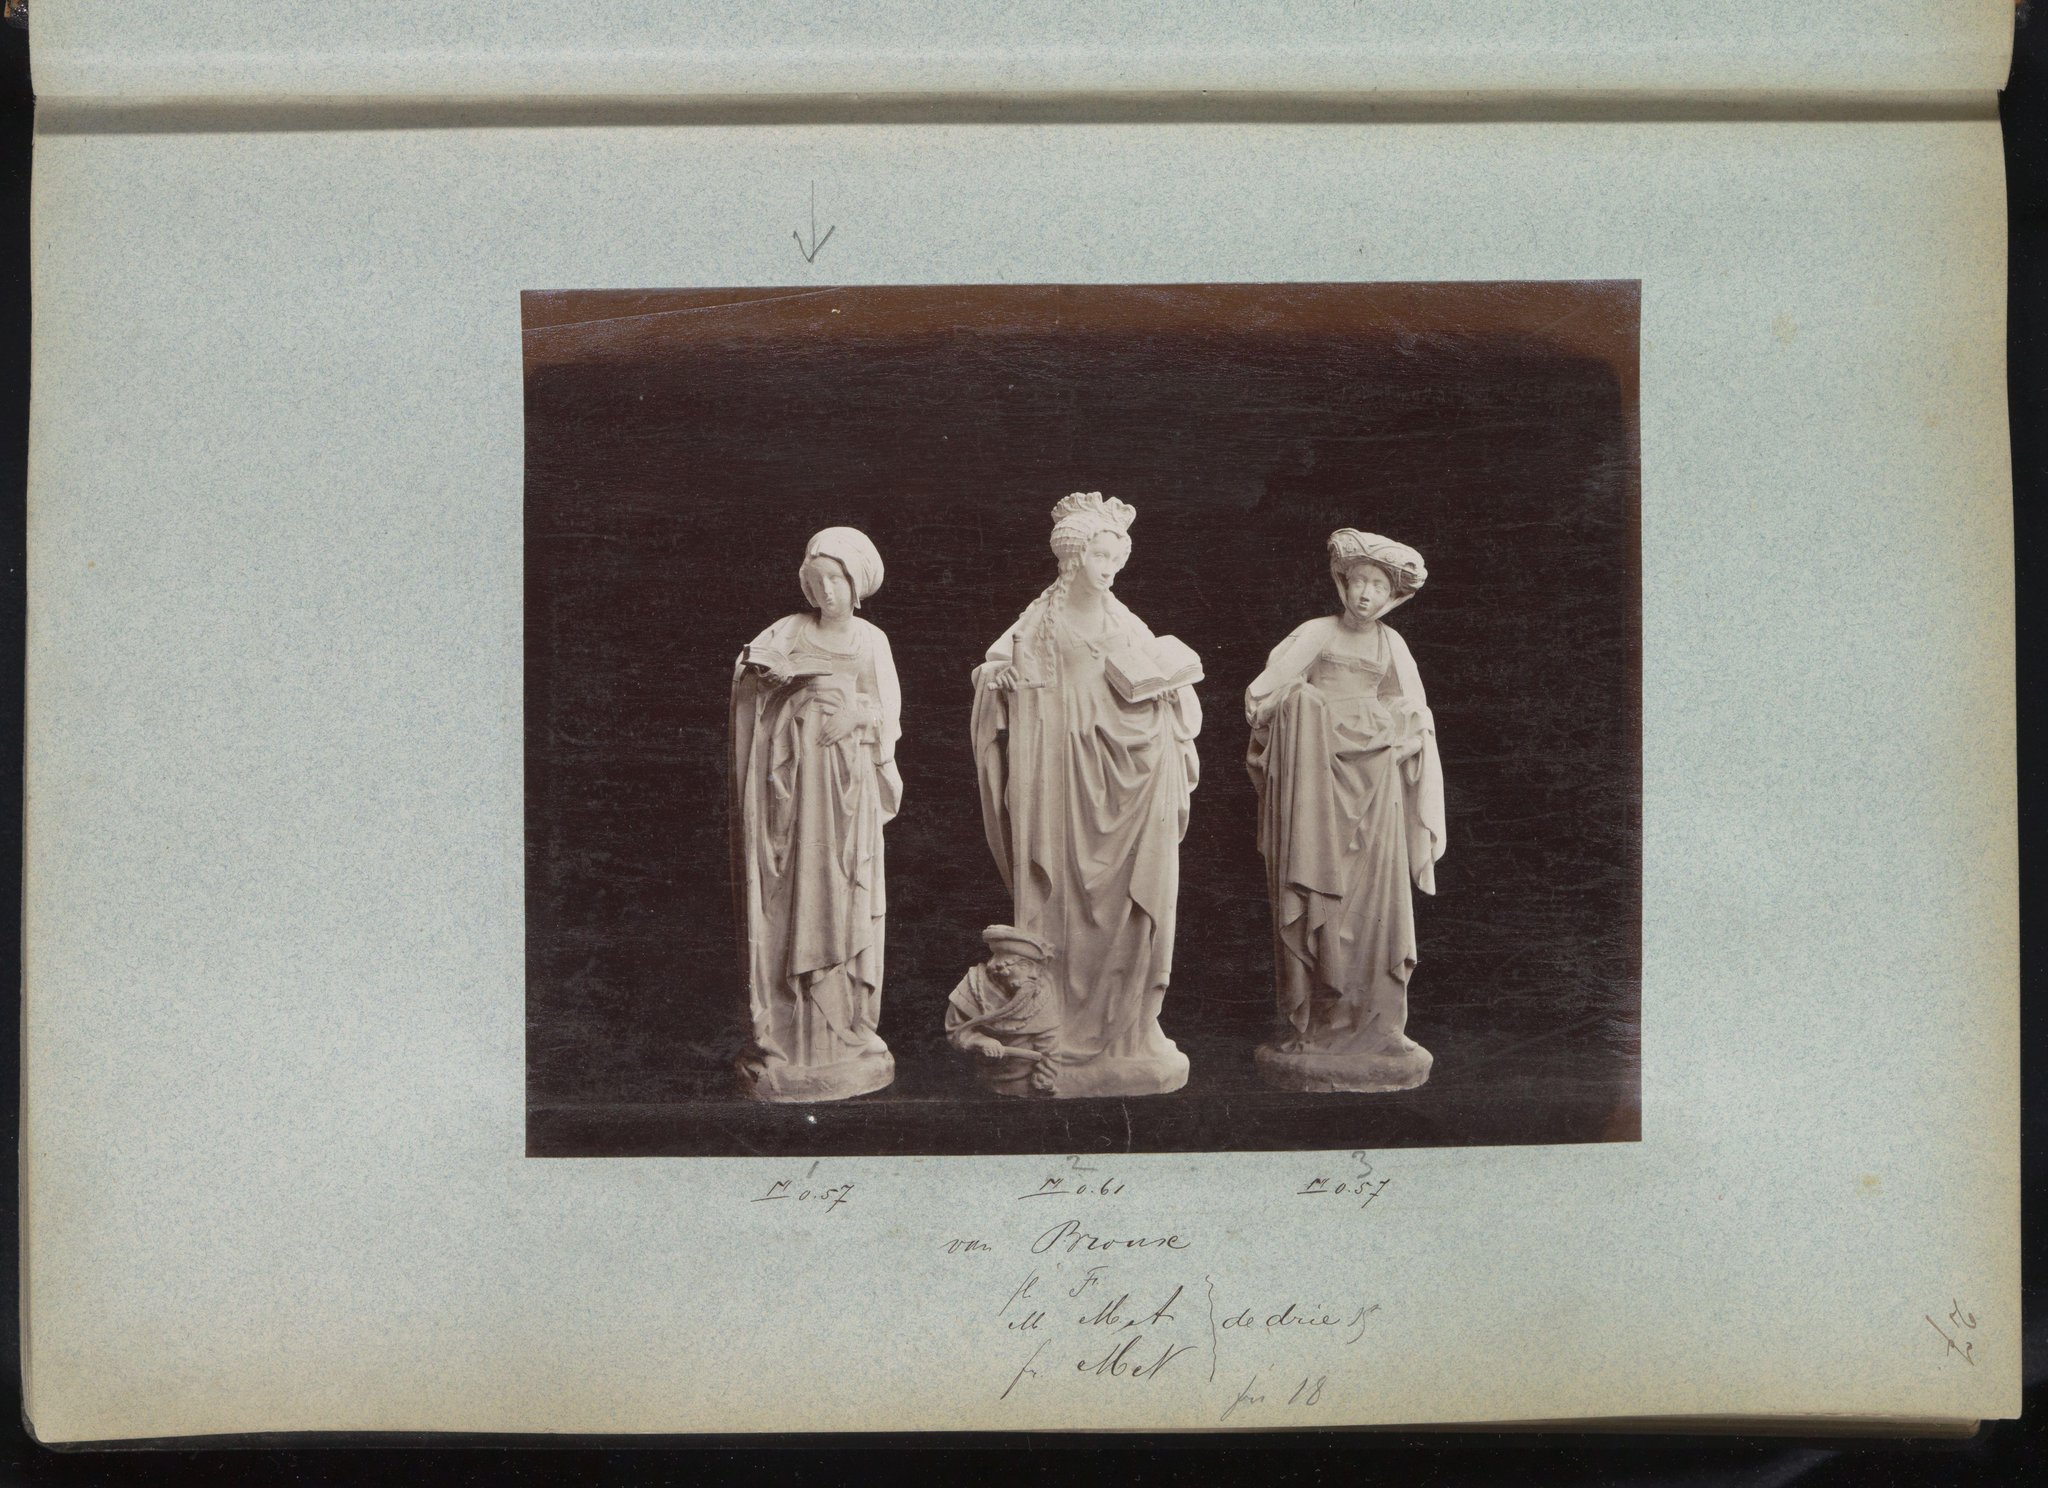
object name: album leaf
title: Drie gipsen afgietsels van sculpturen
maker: Anonymous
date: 1875-1900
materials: paper, photographic support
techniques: albumen print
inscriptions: annotation, annotation: ‘M 0.57 M 0.61 M 0.57’